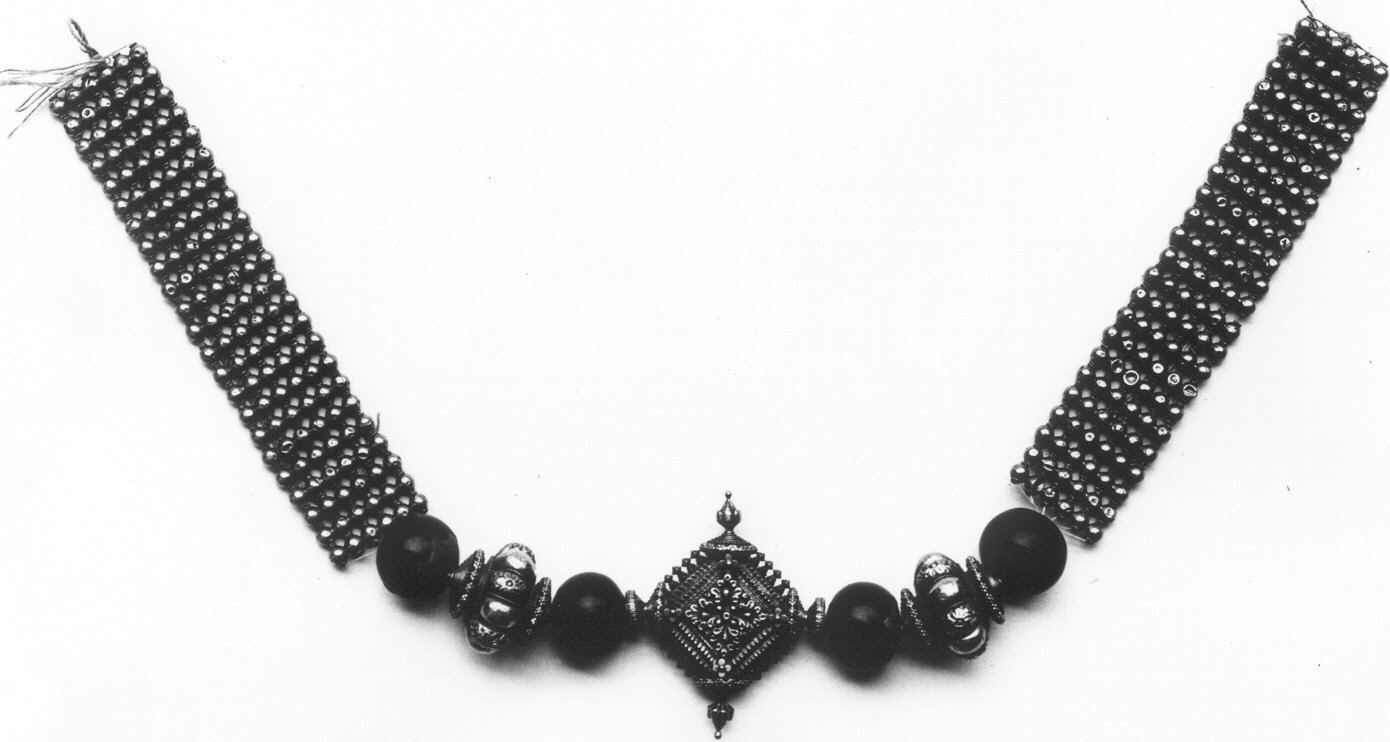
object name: necklet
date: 1701-1800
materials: gold, lacquer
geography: central india